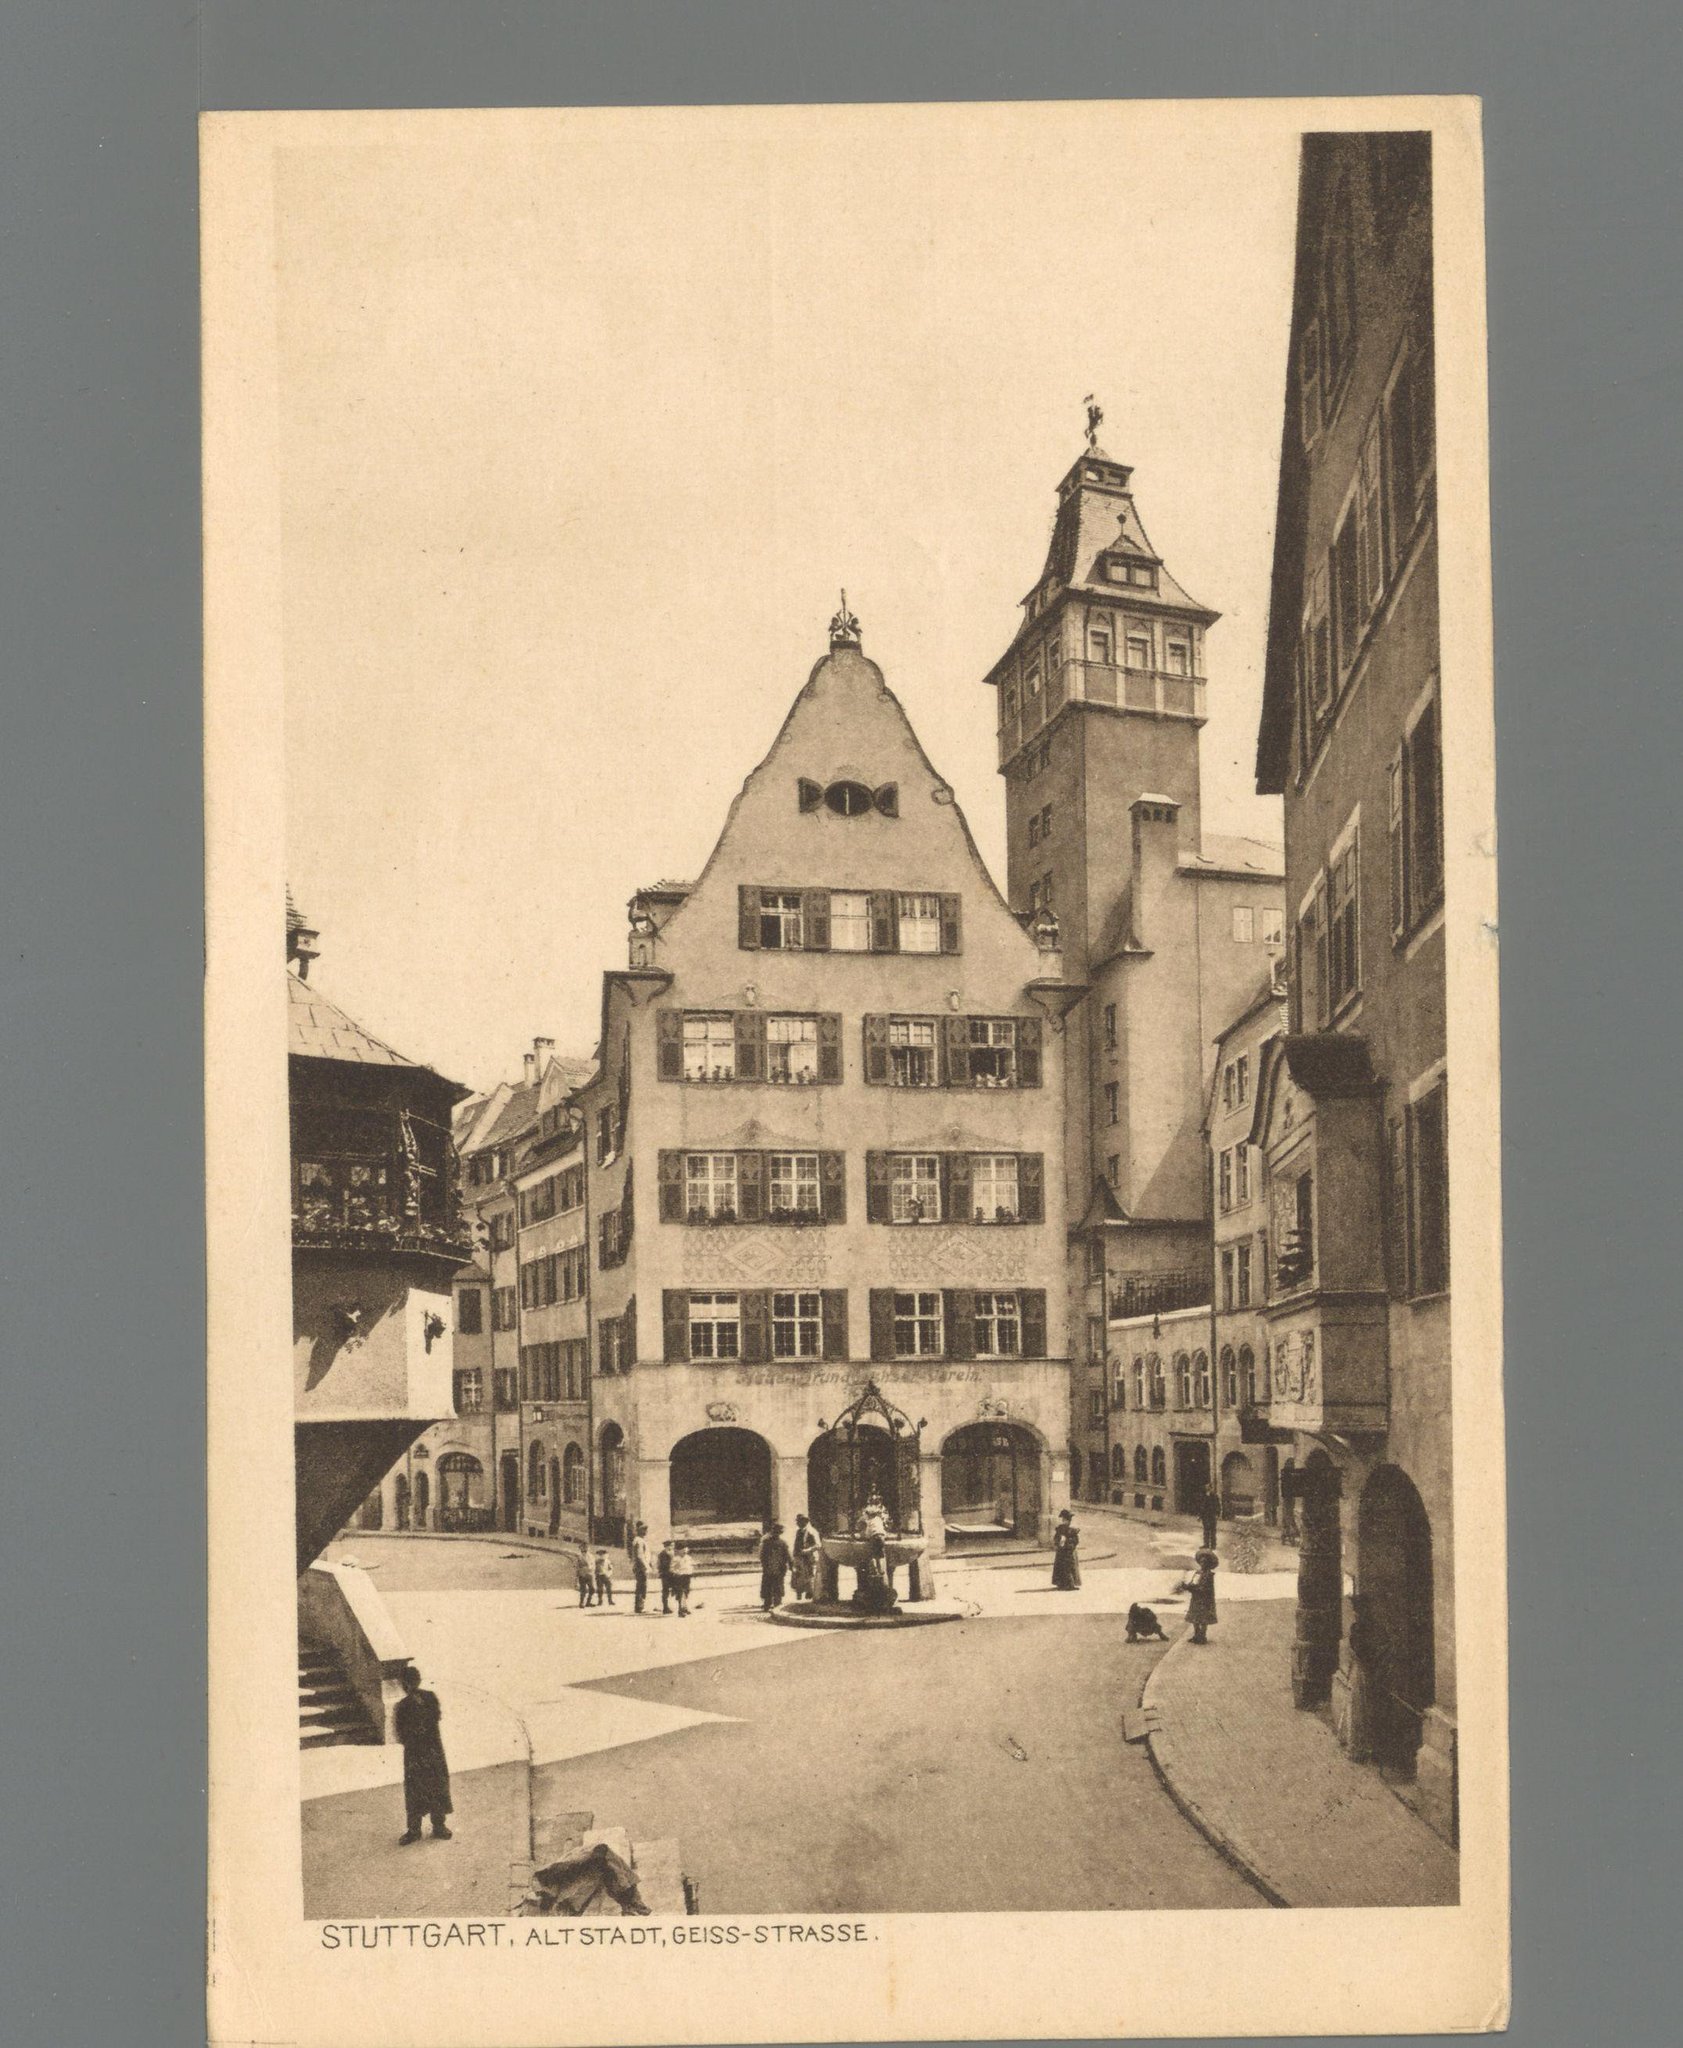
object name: ansichtkaart, prentbriefkaart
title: Stuttgart, Altstadt, Geiss-Strasse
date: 1905-1909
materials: cardboard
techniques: photoaquatint, writing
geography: stuttgart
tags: square, place, circus, etc., monument, statue